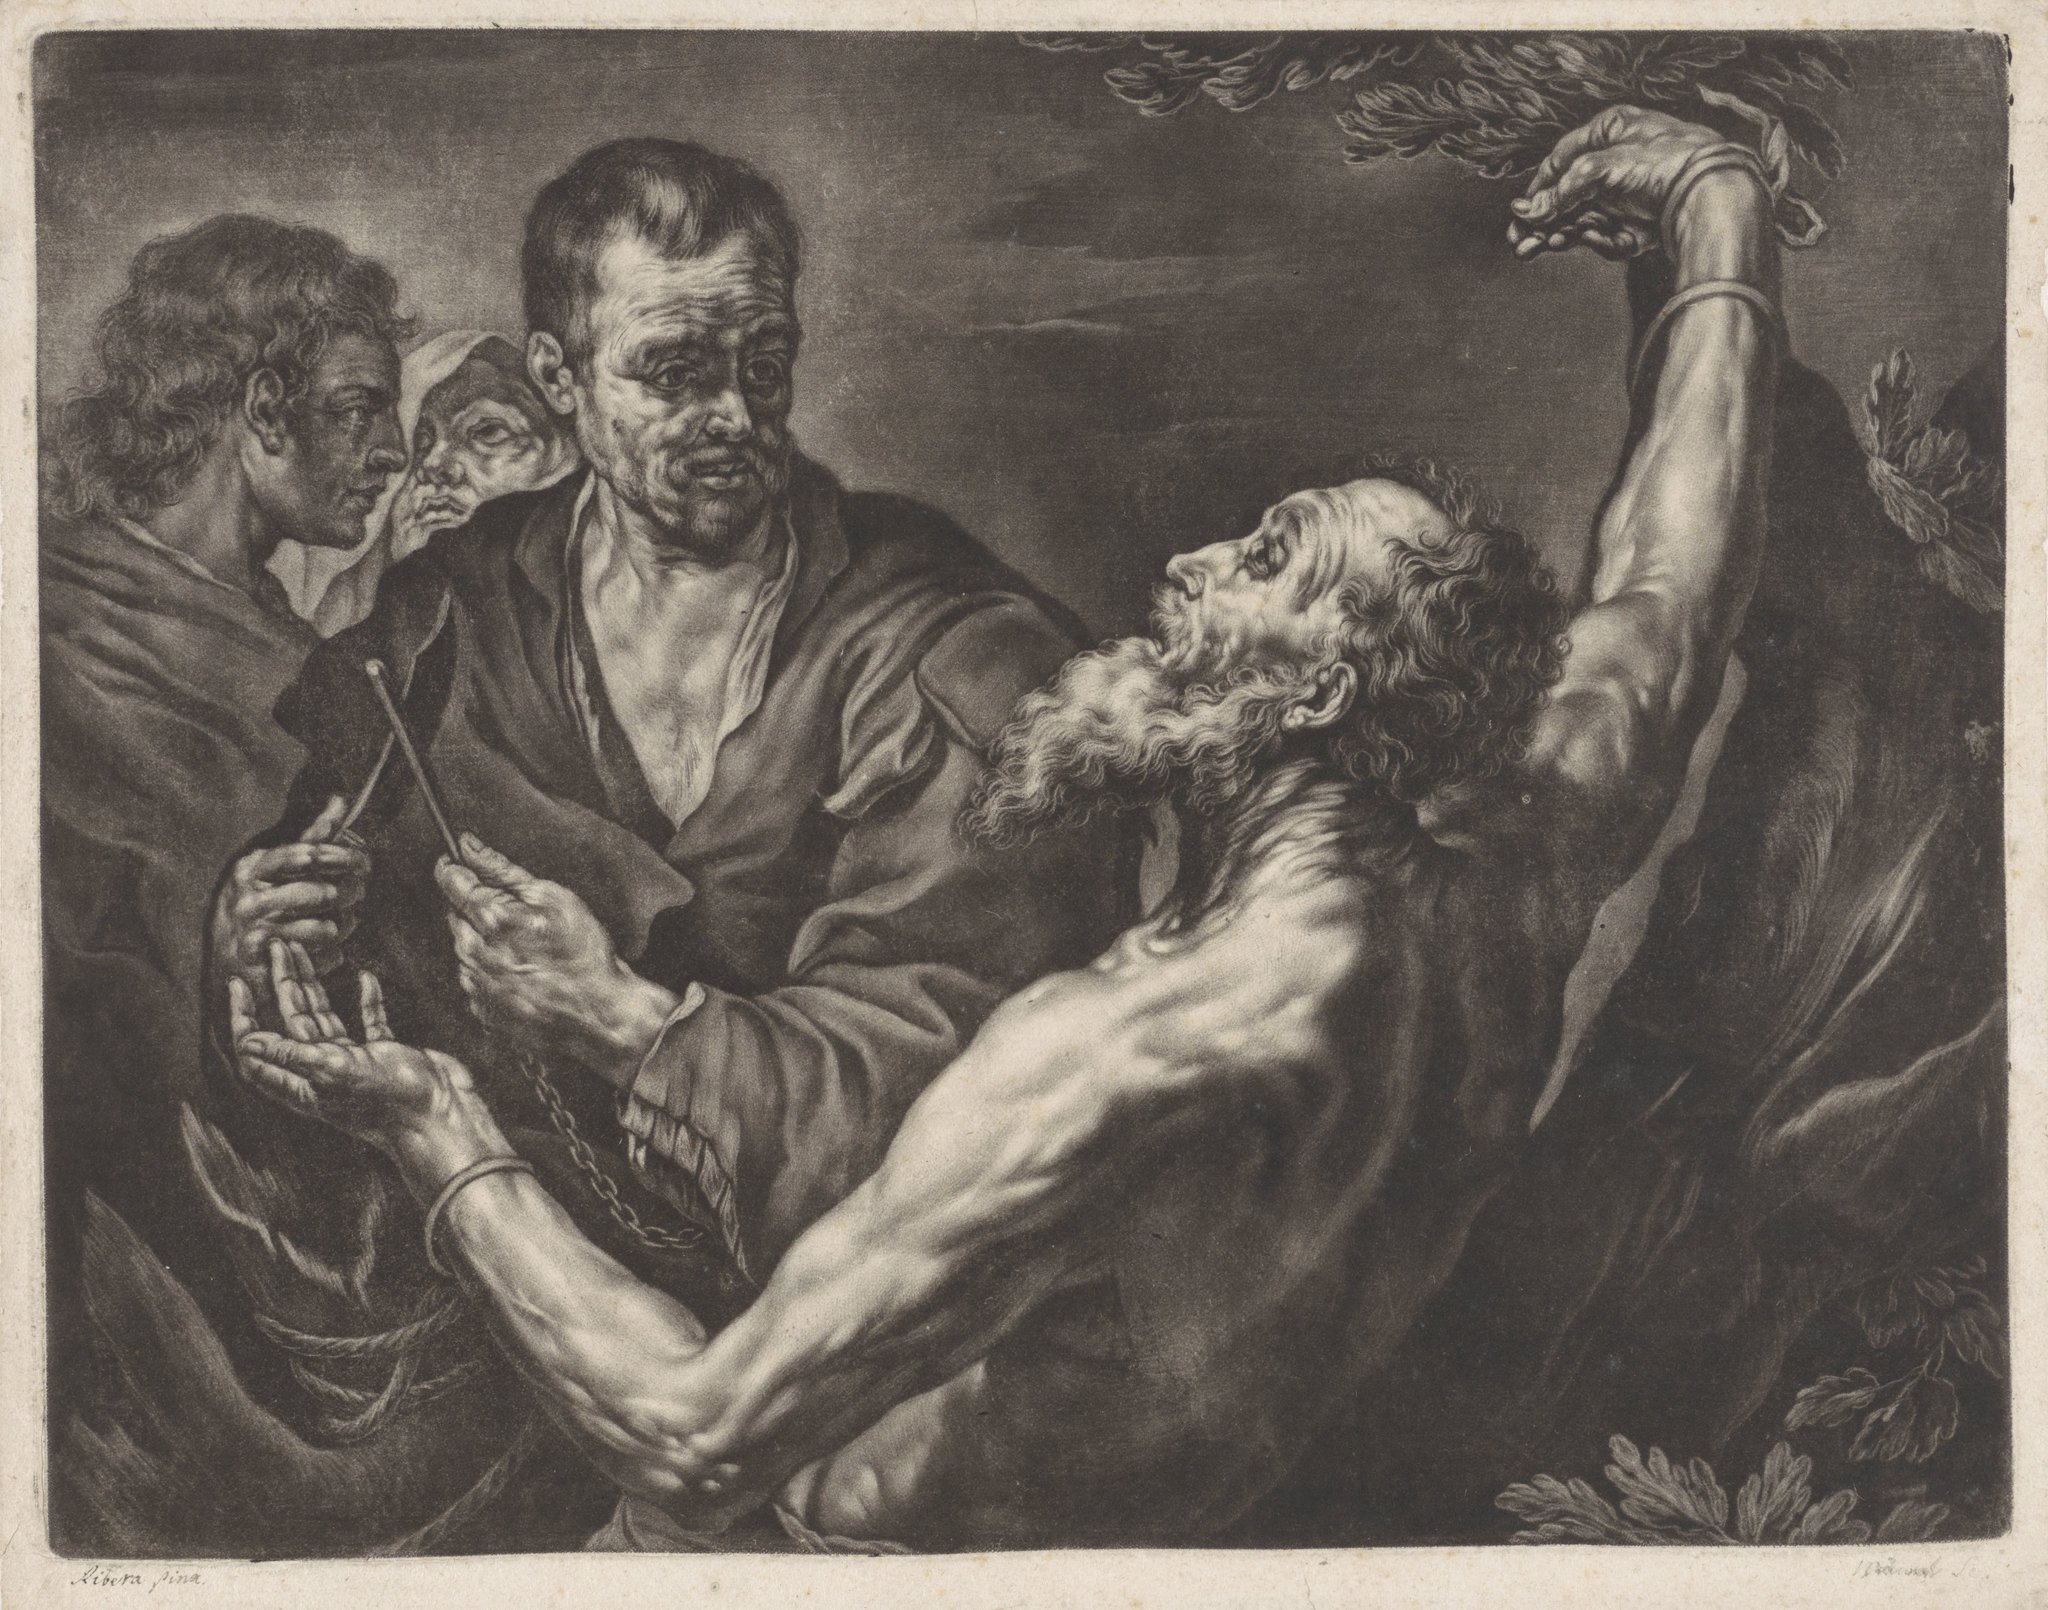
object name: print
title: Martelaarschap van de H. Bartholomeus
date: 1650-1800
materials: paper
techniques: mezzotint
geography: netherlands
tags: bartholomew flayed alive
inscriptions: collector's mark: Lugt 2228, collector's mark: Lugt 2760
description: De heilige Bartholomeus, ten halven lijve, van opzij gezien, met zijn armen aan een boom gebonden. Voor hem staat de beul die zijn mes slijpt. Daarachter twee mannenhoofden.